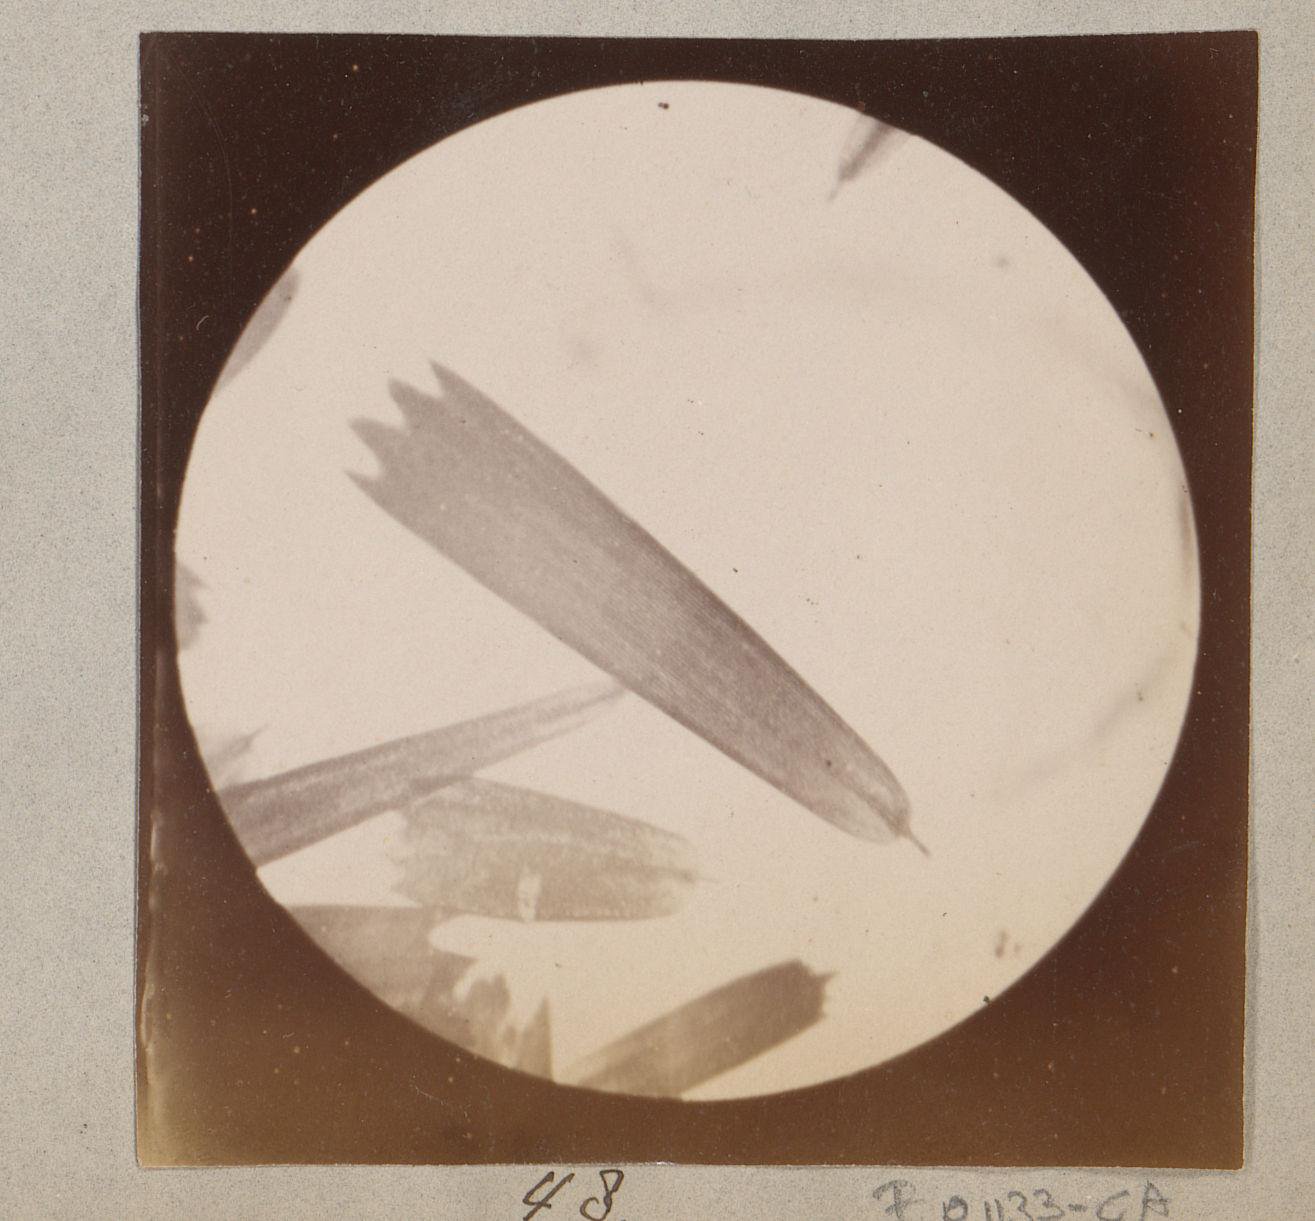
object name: photograph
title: Microscopische opname van schubben van een vlindervleugel, 350 keer vergroot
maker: marinus pieter filbri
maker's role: instrument maker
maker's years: 1852-1917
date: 1887-1888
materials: paper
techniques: albumen print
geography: netherlands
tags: insects: butterfly, netherlands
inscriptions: number: ‘48.’, inscription: ‘No. 48. Benaming Schubjes van de vleugel eener kapel, 350 x vergroot, pose 3 m., Bemerking id.’